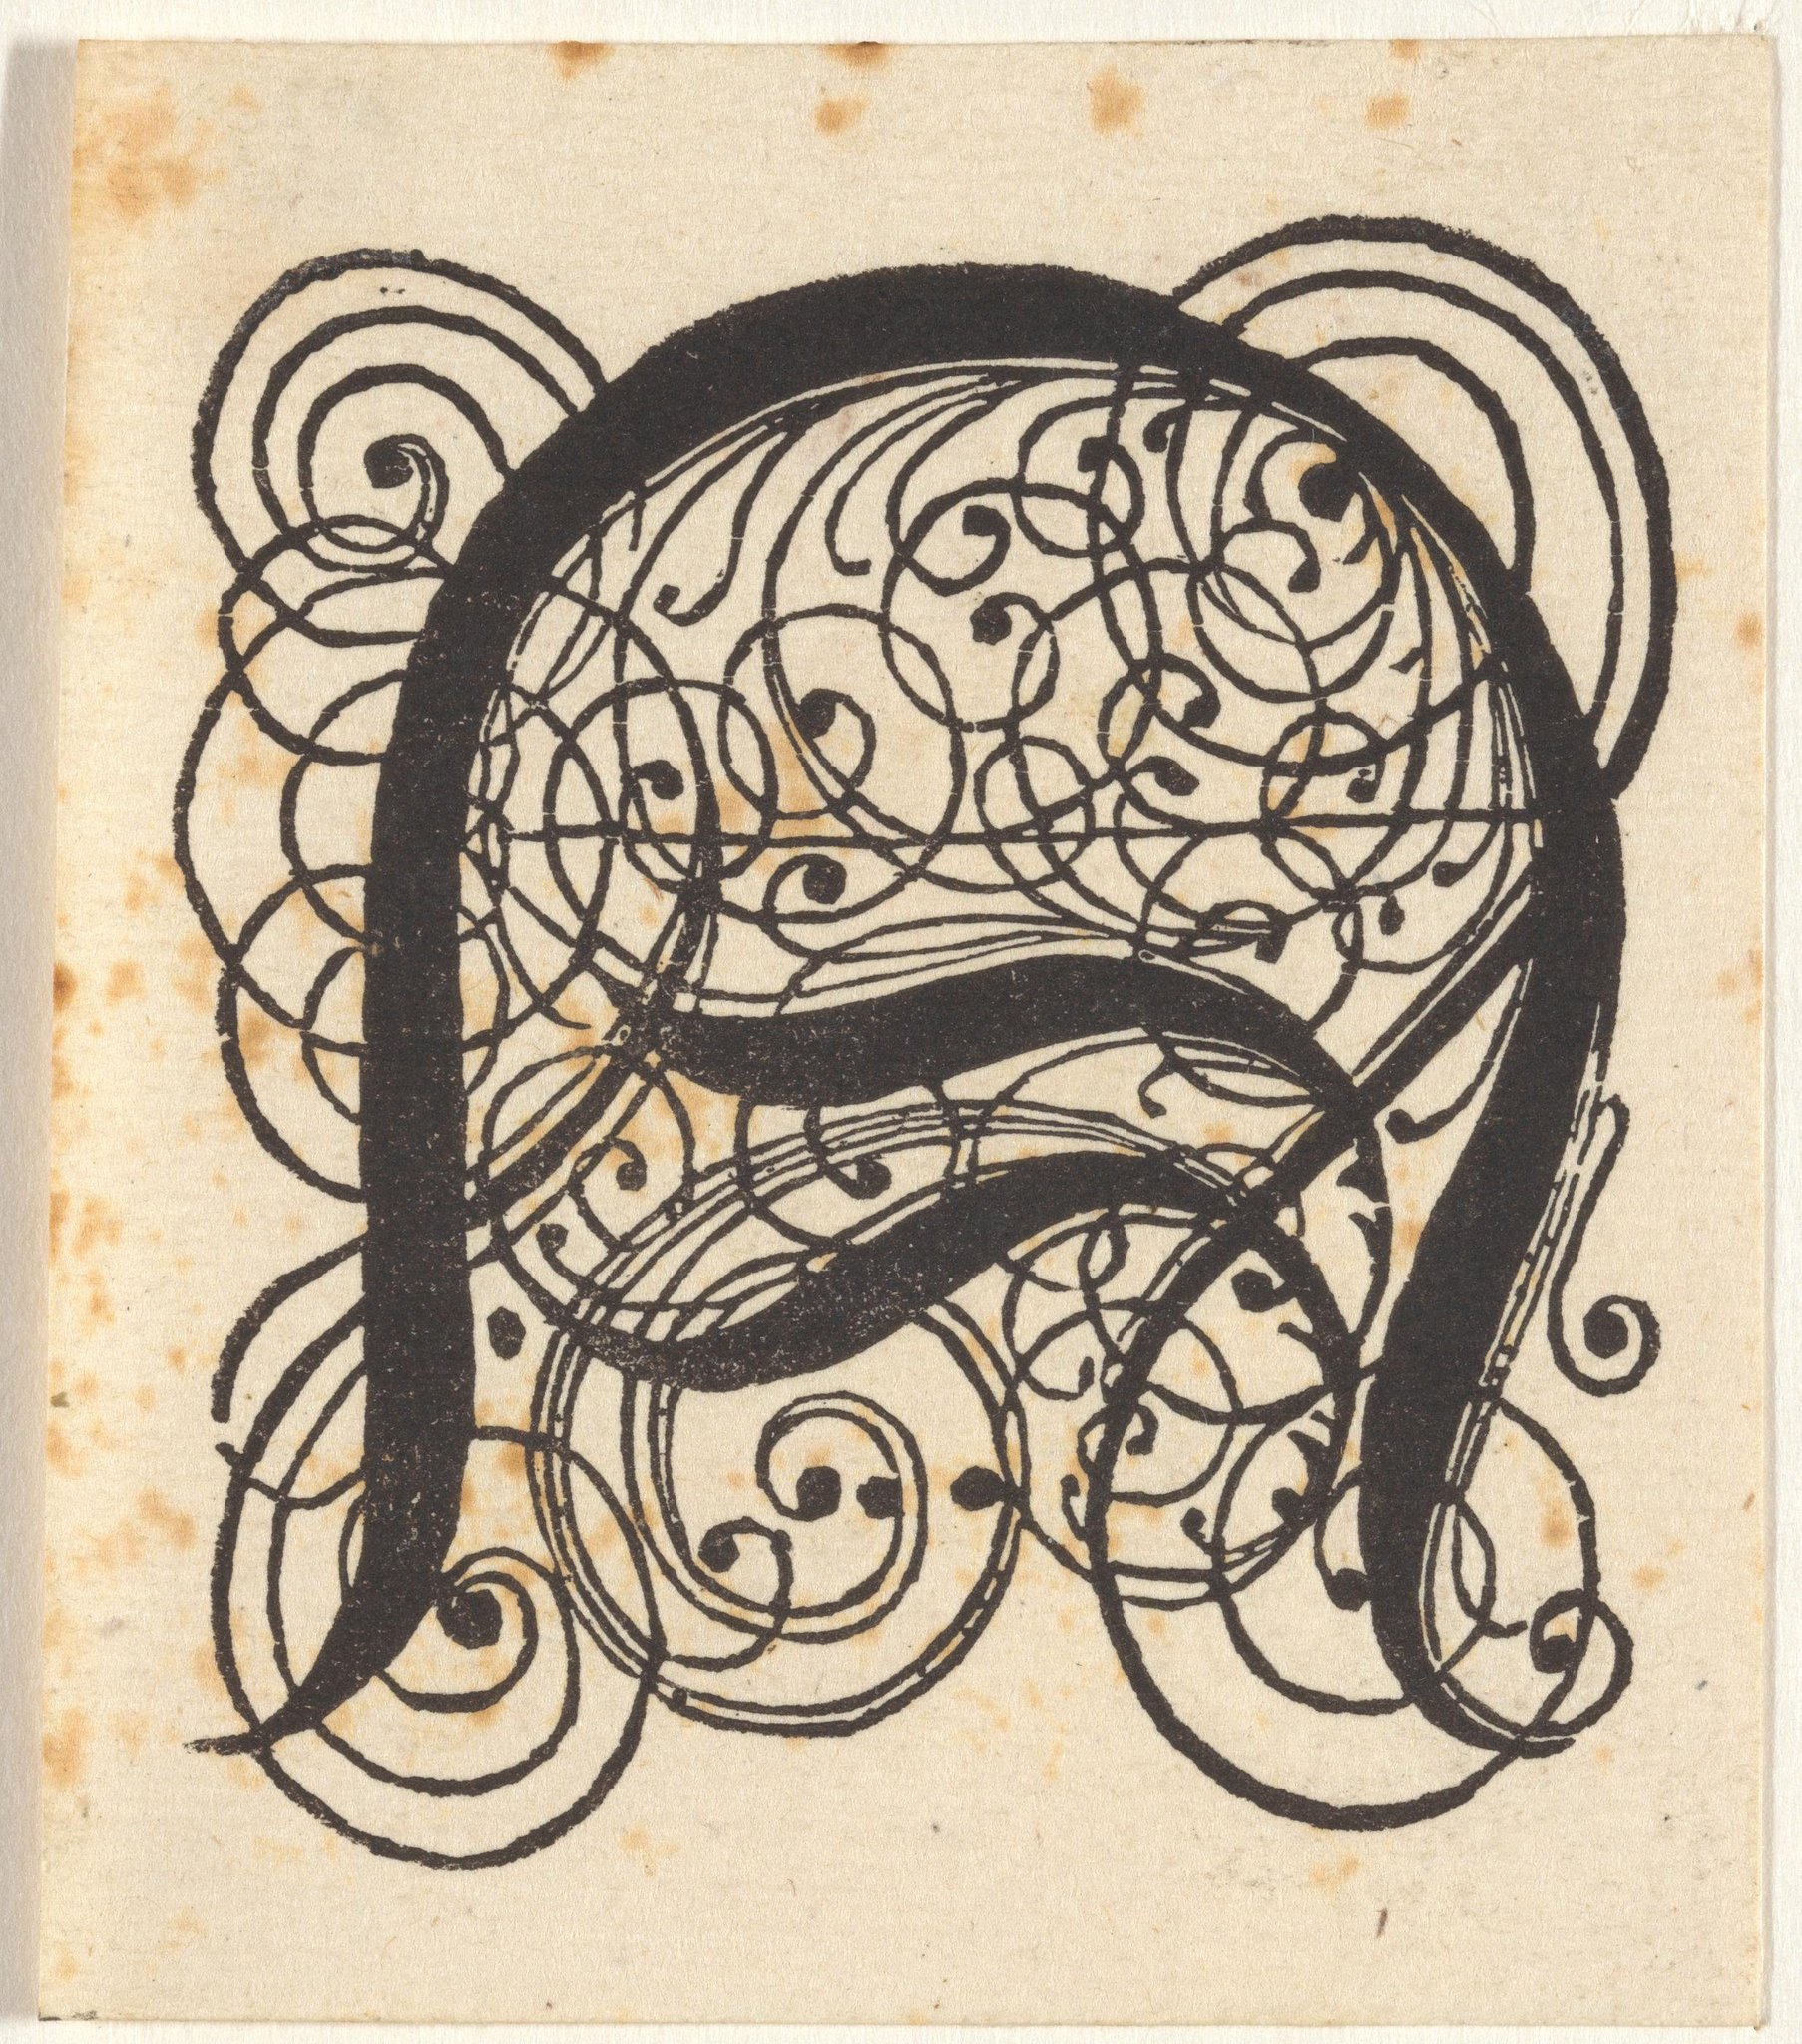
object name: print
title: Letter A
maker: Anonymous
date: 1600-1699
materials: paper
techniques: woodcut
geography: netherlands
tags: fancy letters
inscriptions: collector's mark: Lugt 240